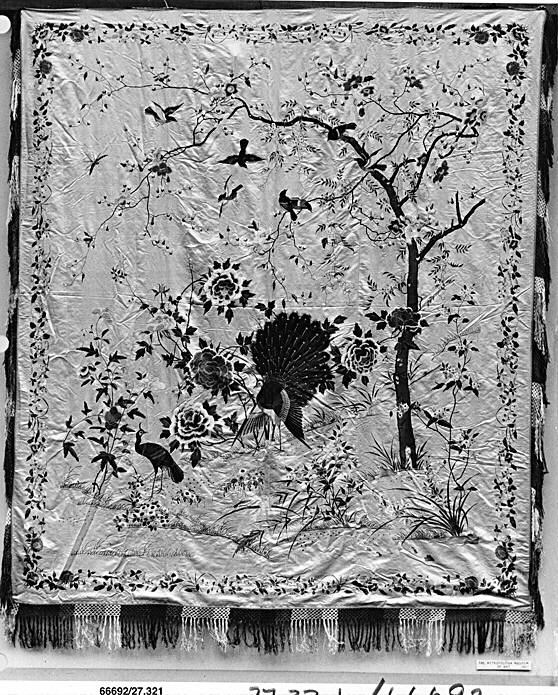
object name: bedspread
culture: chinese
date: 1801-1900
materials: silk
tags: birds,peacocks